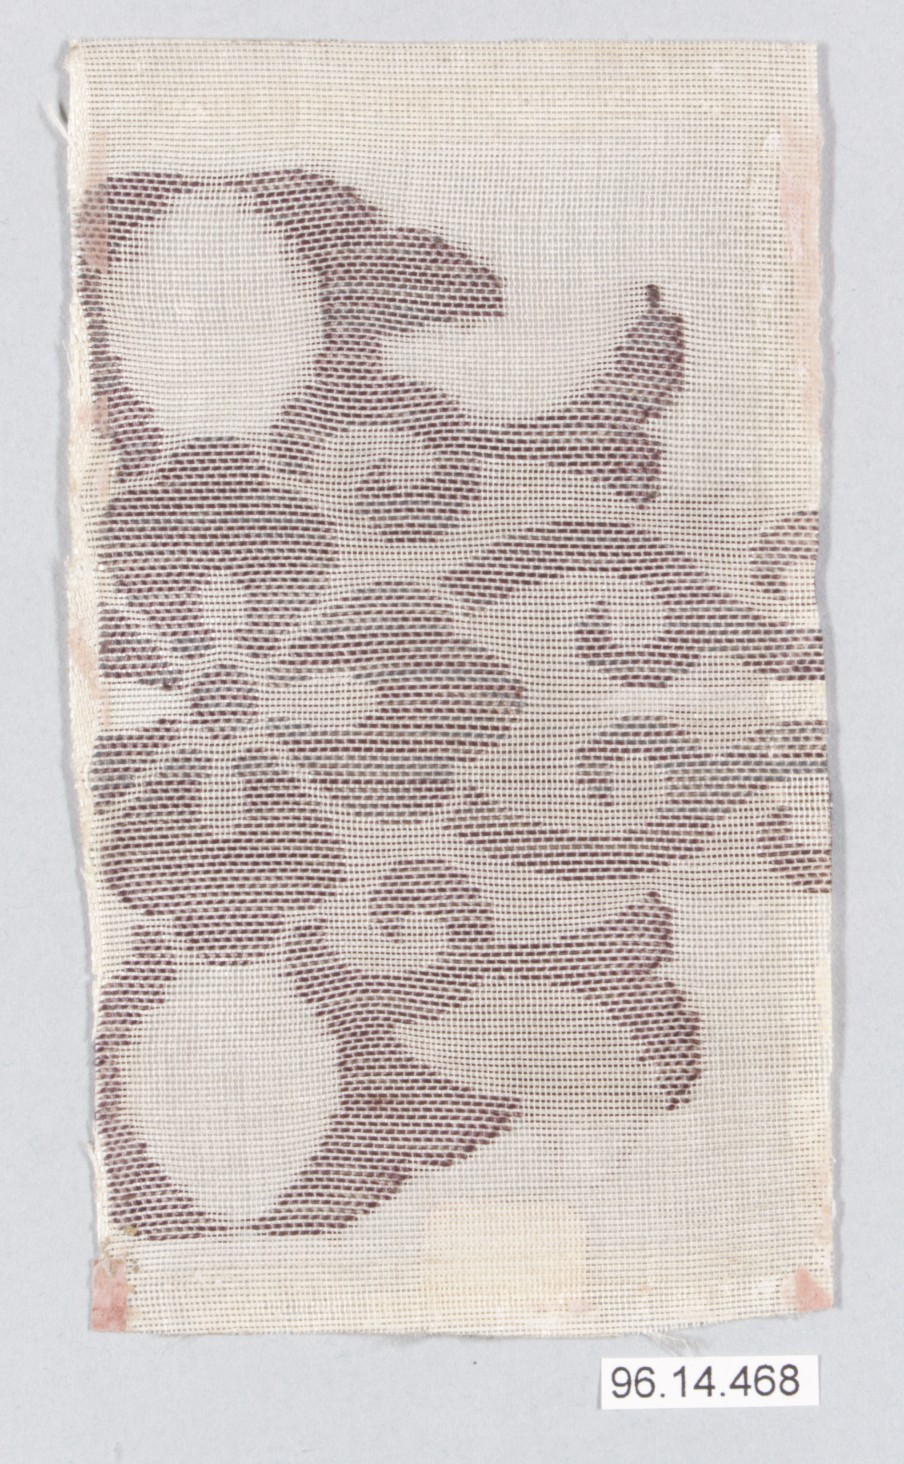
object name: piece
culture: japanese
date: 1701-1900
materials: silk